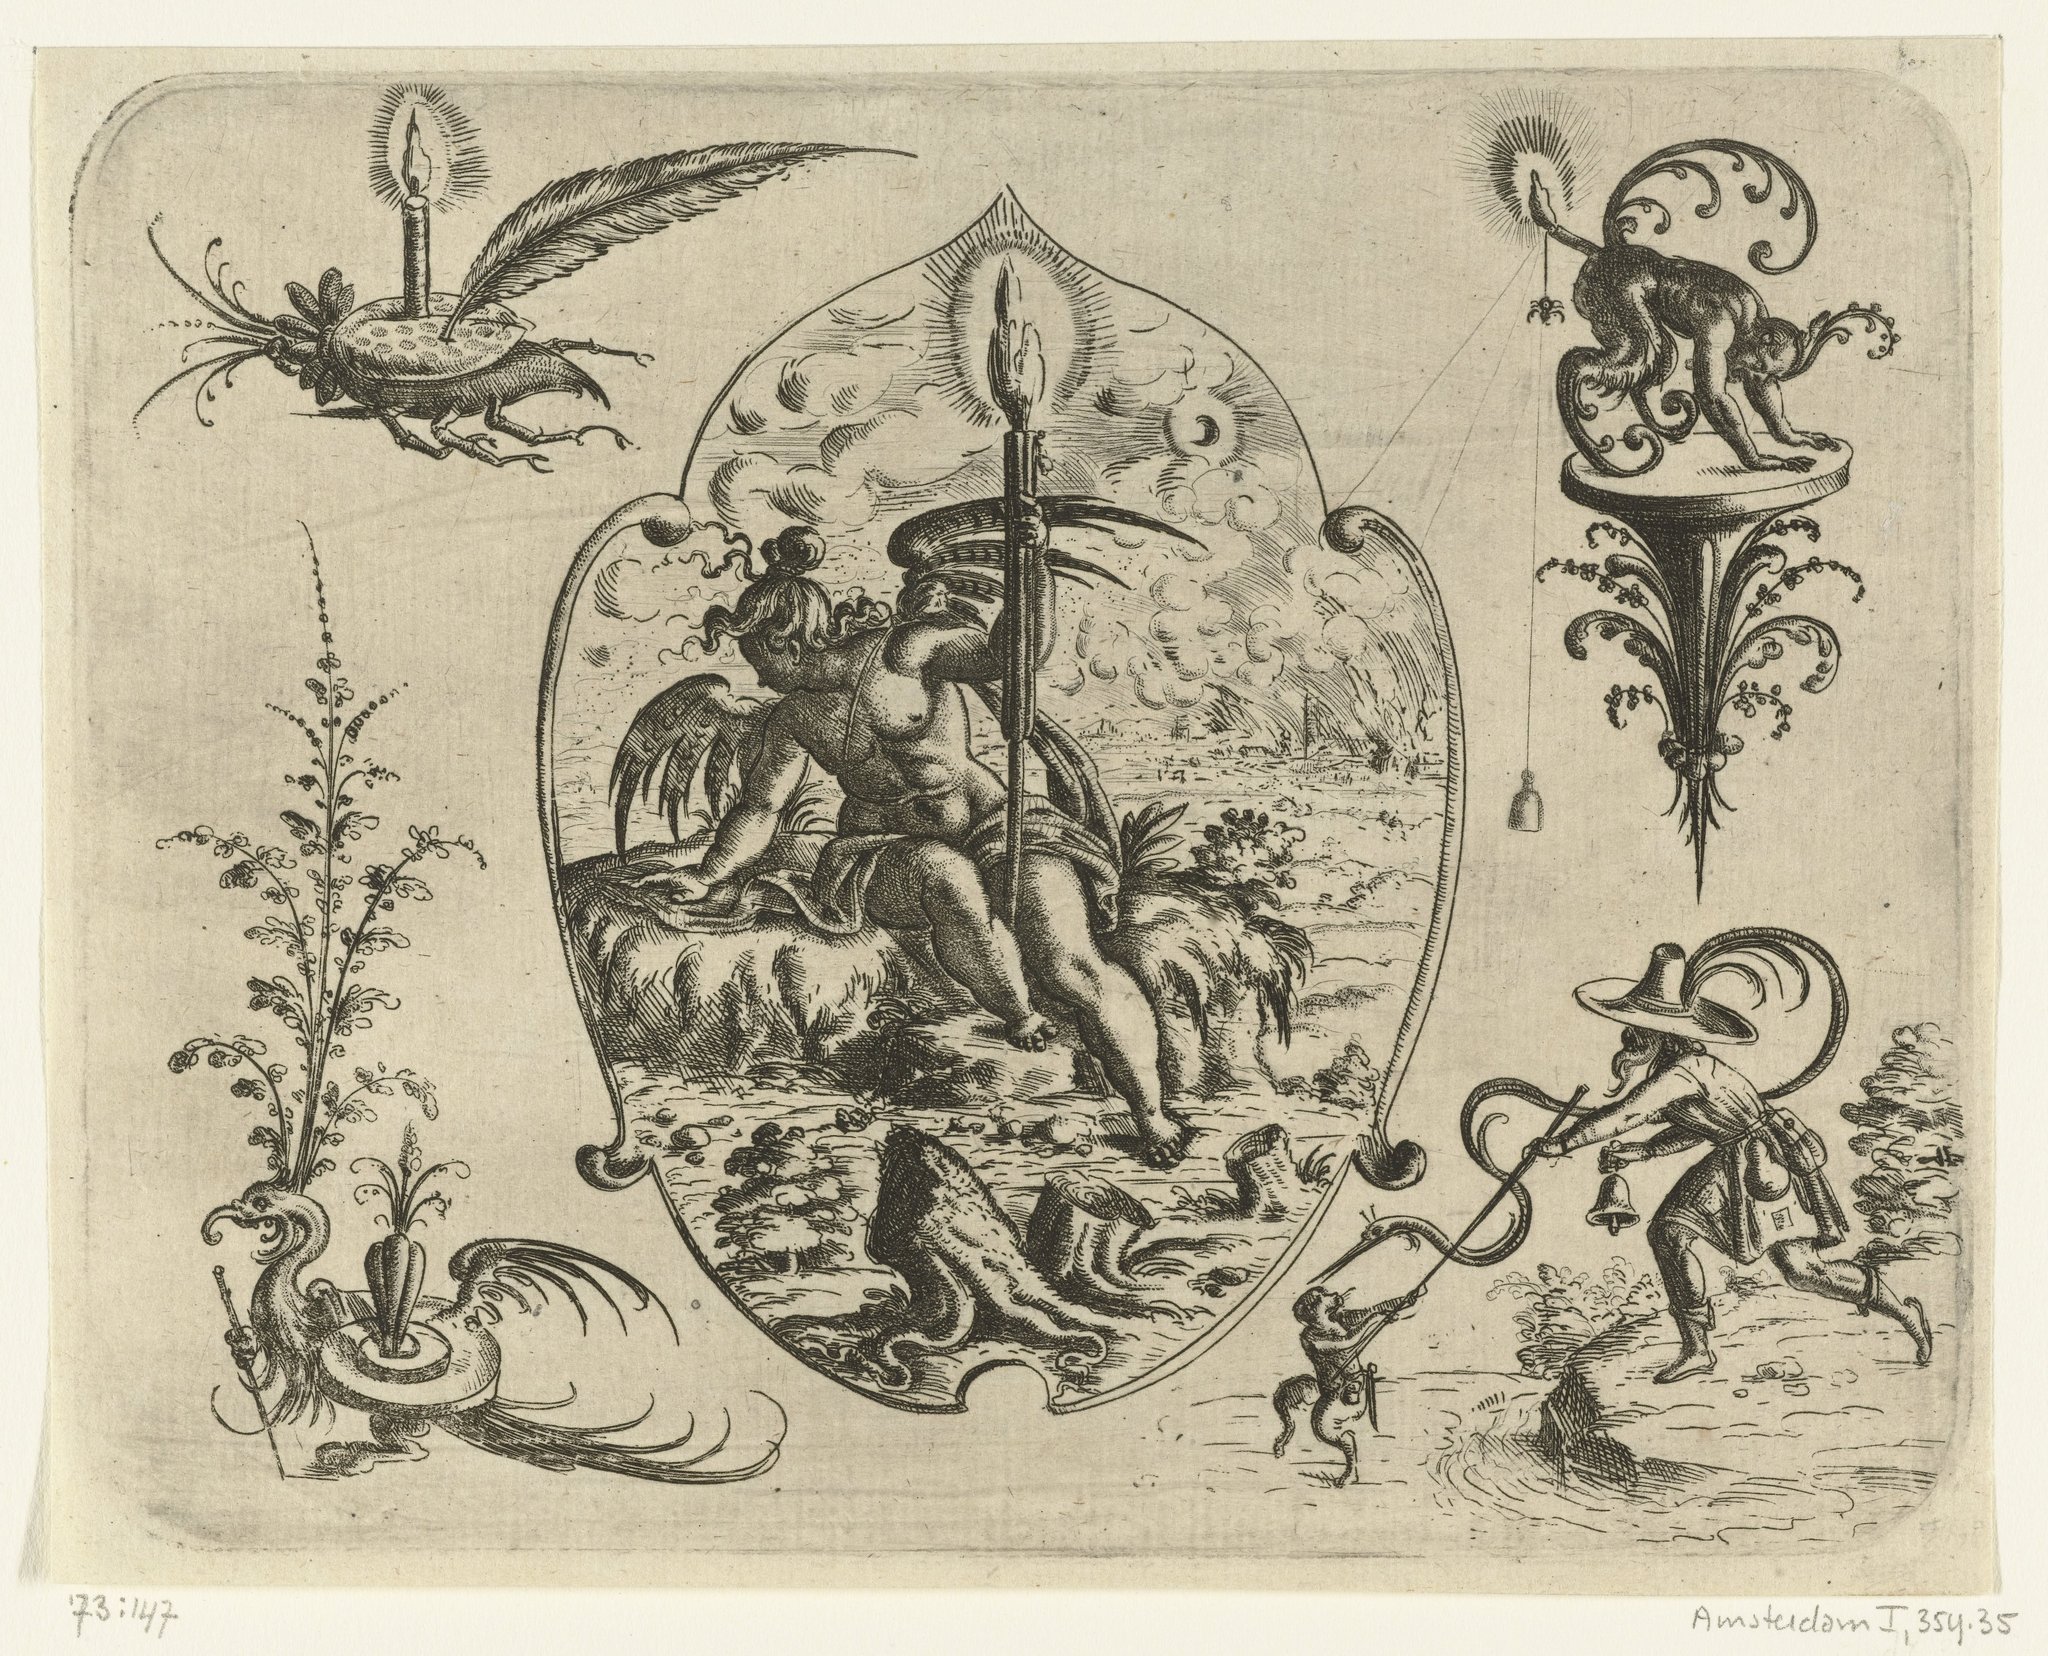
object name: ornament print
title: Das Neuw Grottesken Buch Nürnberg 1610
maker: christoph jamnitzer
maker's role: draughtsman, goldsmith, print maker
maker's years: 1563-1618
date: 1573-1610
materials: paper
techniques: etching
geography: germany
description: De engel zit op een heuvel met een brandende fakkel in de hand. Blad uit een serie vlakdecoraties met grotesken, cartouches, ovalen, mascarons, putti en fantastische wezens. De serie bestaat uit drie titelbladen, twee tekstbladen met de opdracht en het voorwoord en 60 bladen, verdeeld over drie boeken.